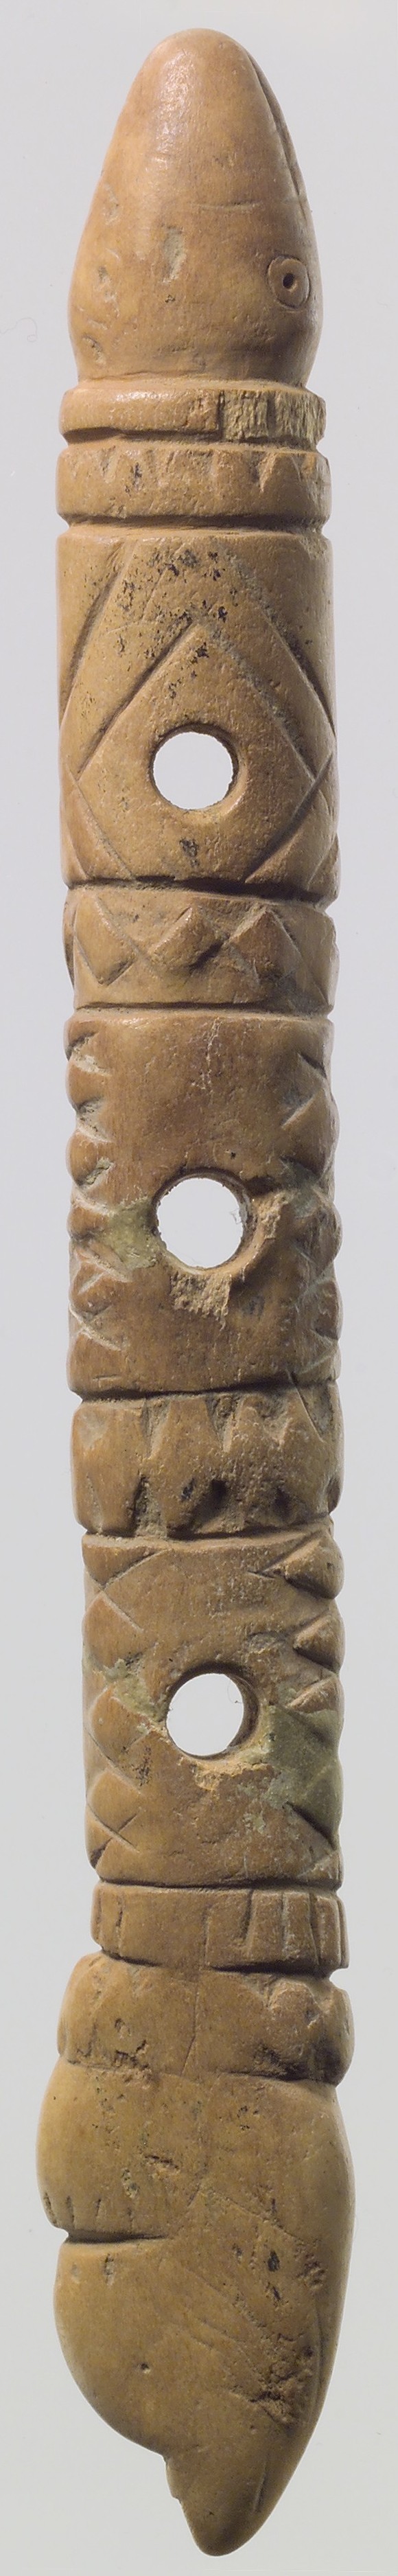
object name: horse bit cheekpiece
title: Horse bit cheekpiece in form of a snake's head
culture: scythian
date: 700-601 BCE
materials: bone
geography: iran